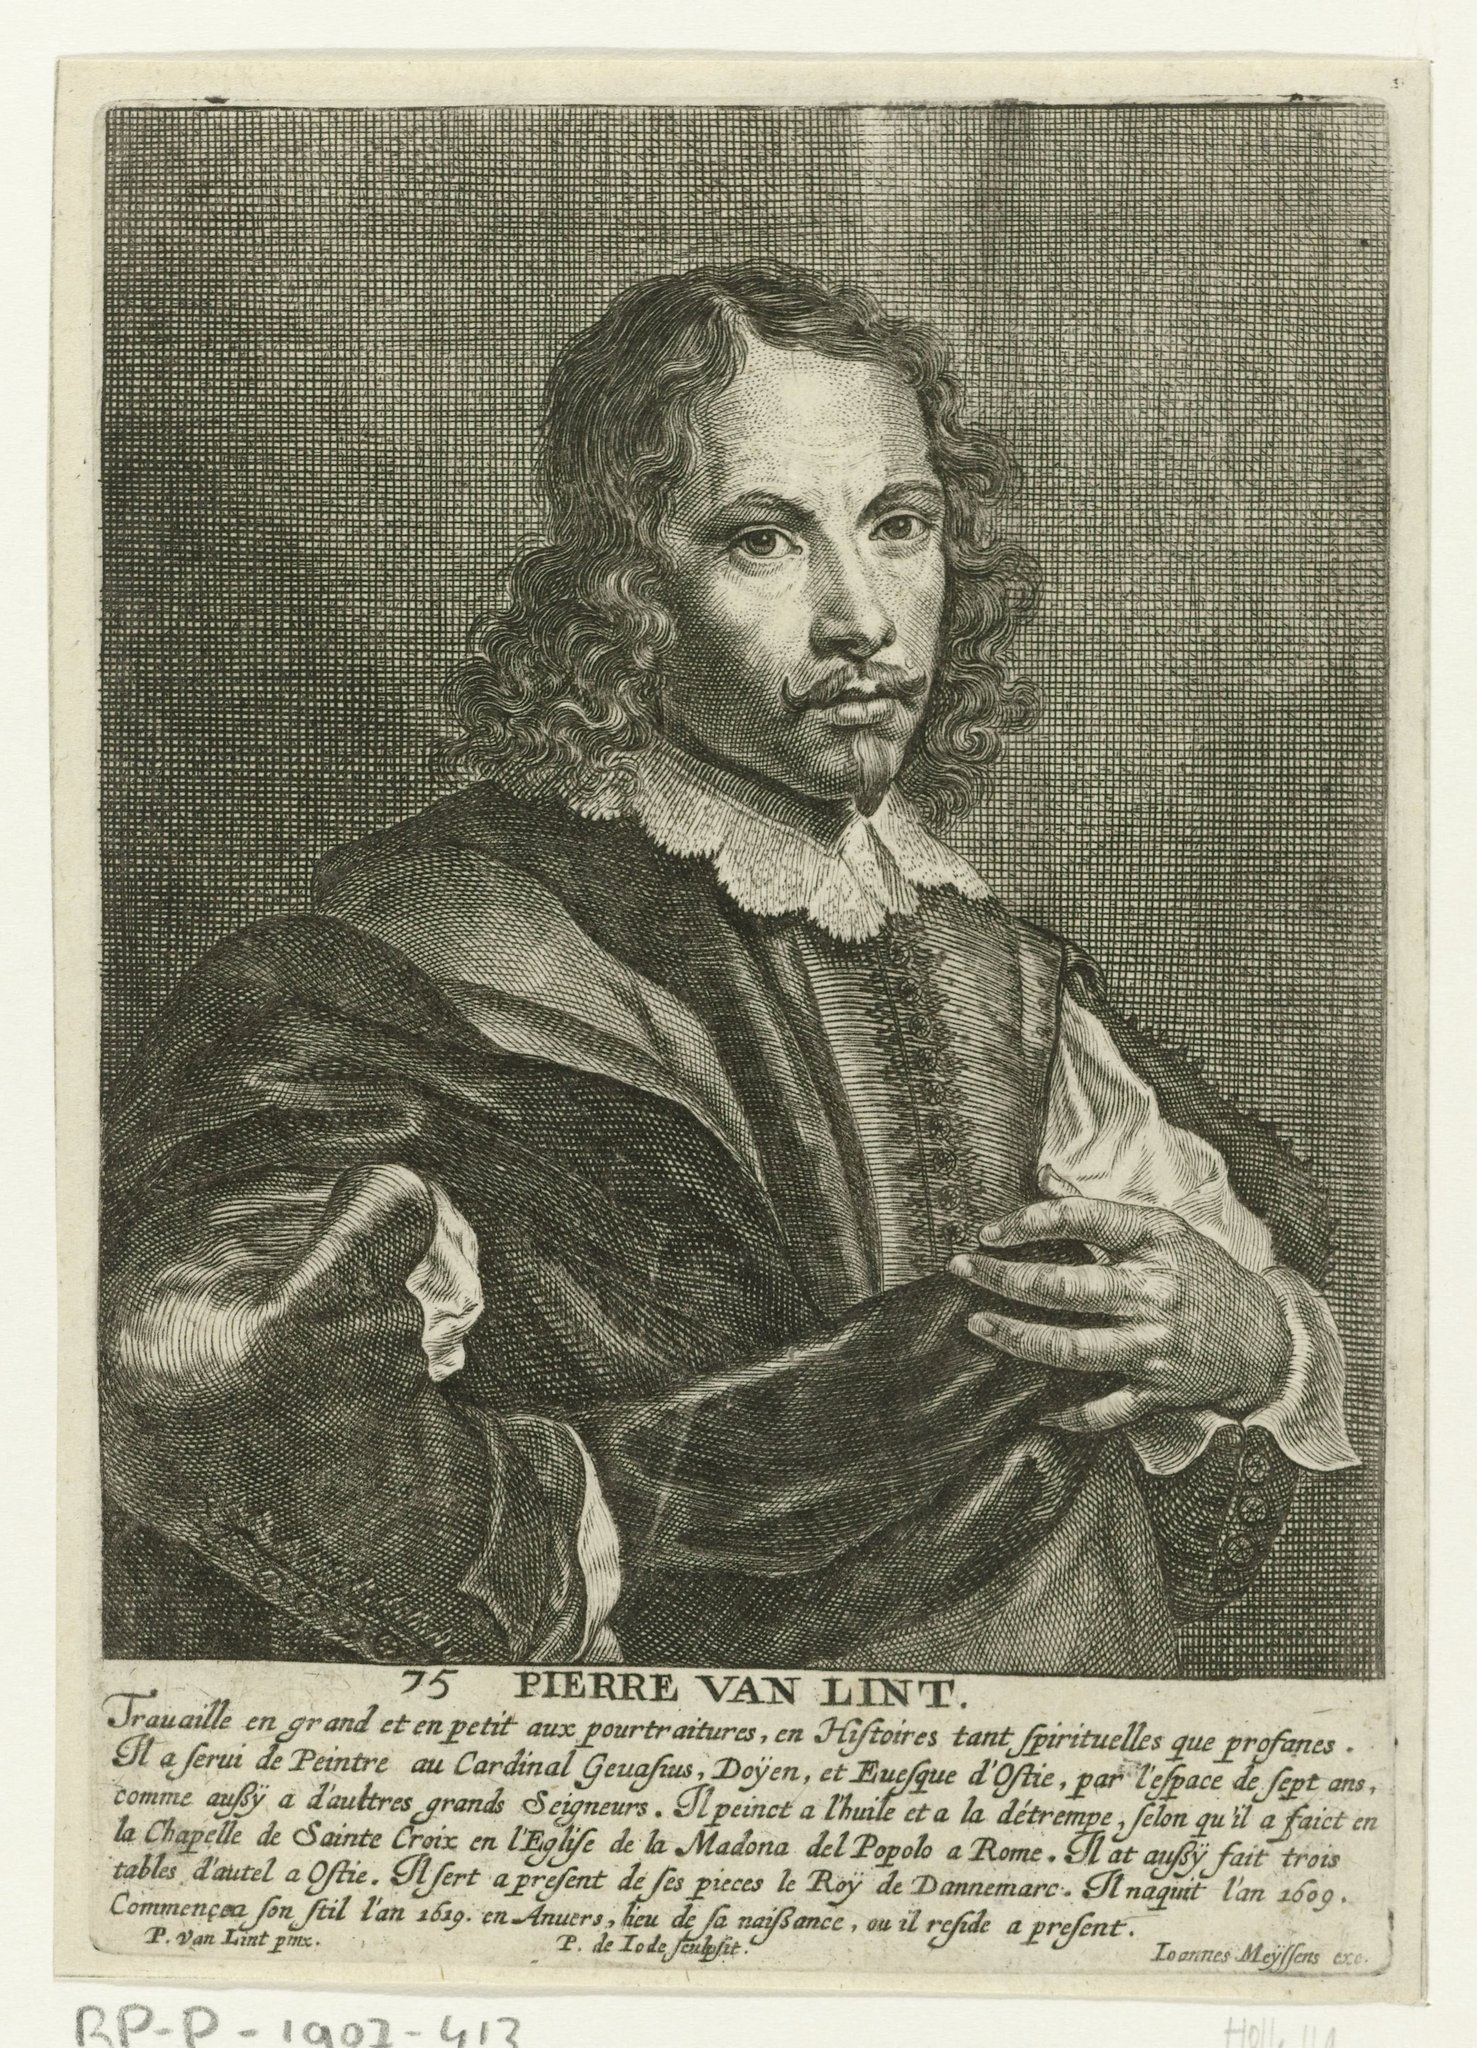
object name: print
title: Portret van Peter van Lint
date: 1628-1670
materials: paper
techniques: engraving, etching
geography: antwerp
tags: antwerp, painter, print maker, draughtsman, peter van lint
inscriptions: collector's mark: Lugt 2228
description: Portret van Peter van Lint, ten halven lijve. In de marge het getal 75, de naam van de geportretteerde en een zesregelig onderschrift in het Frans.